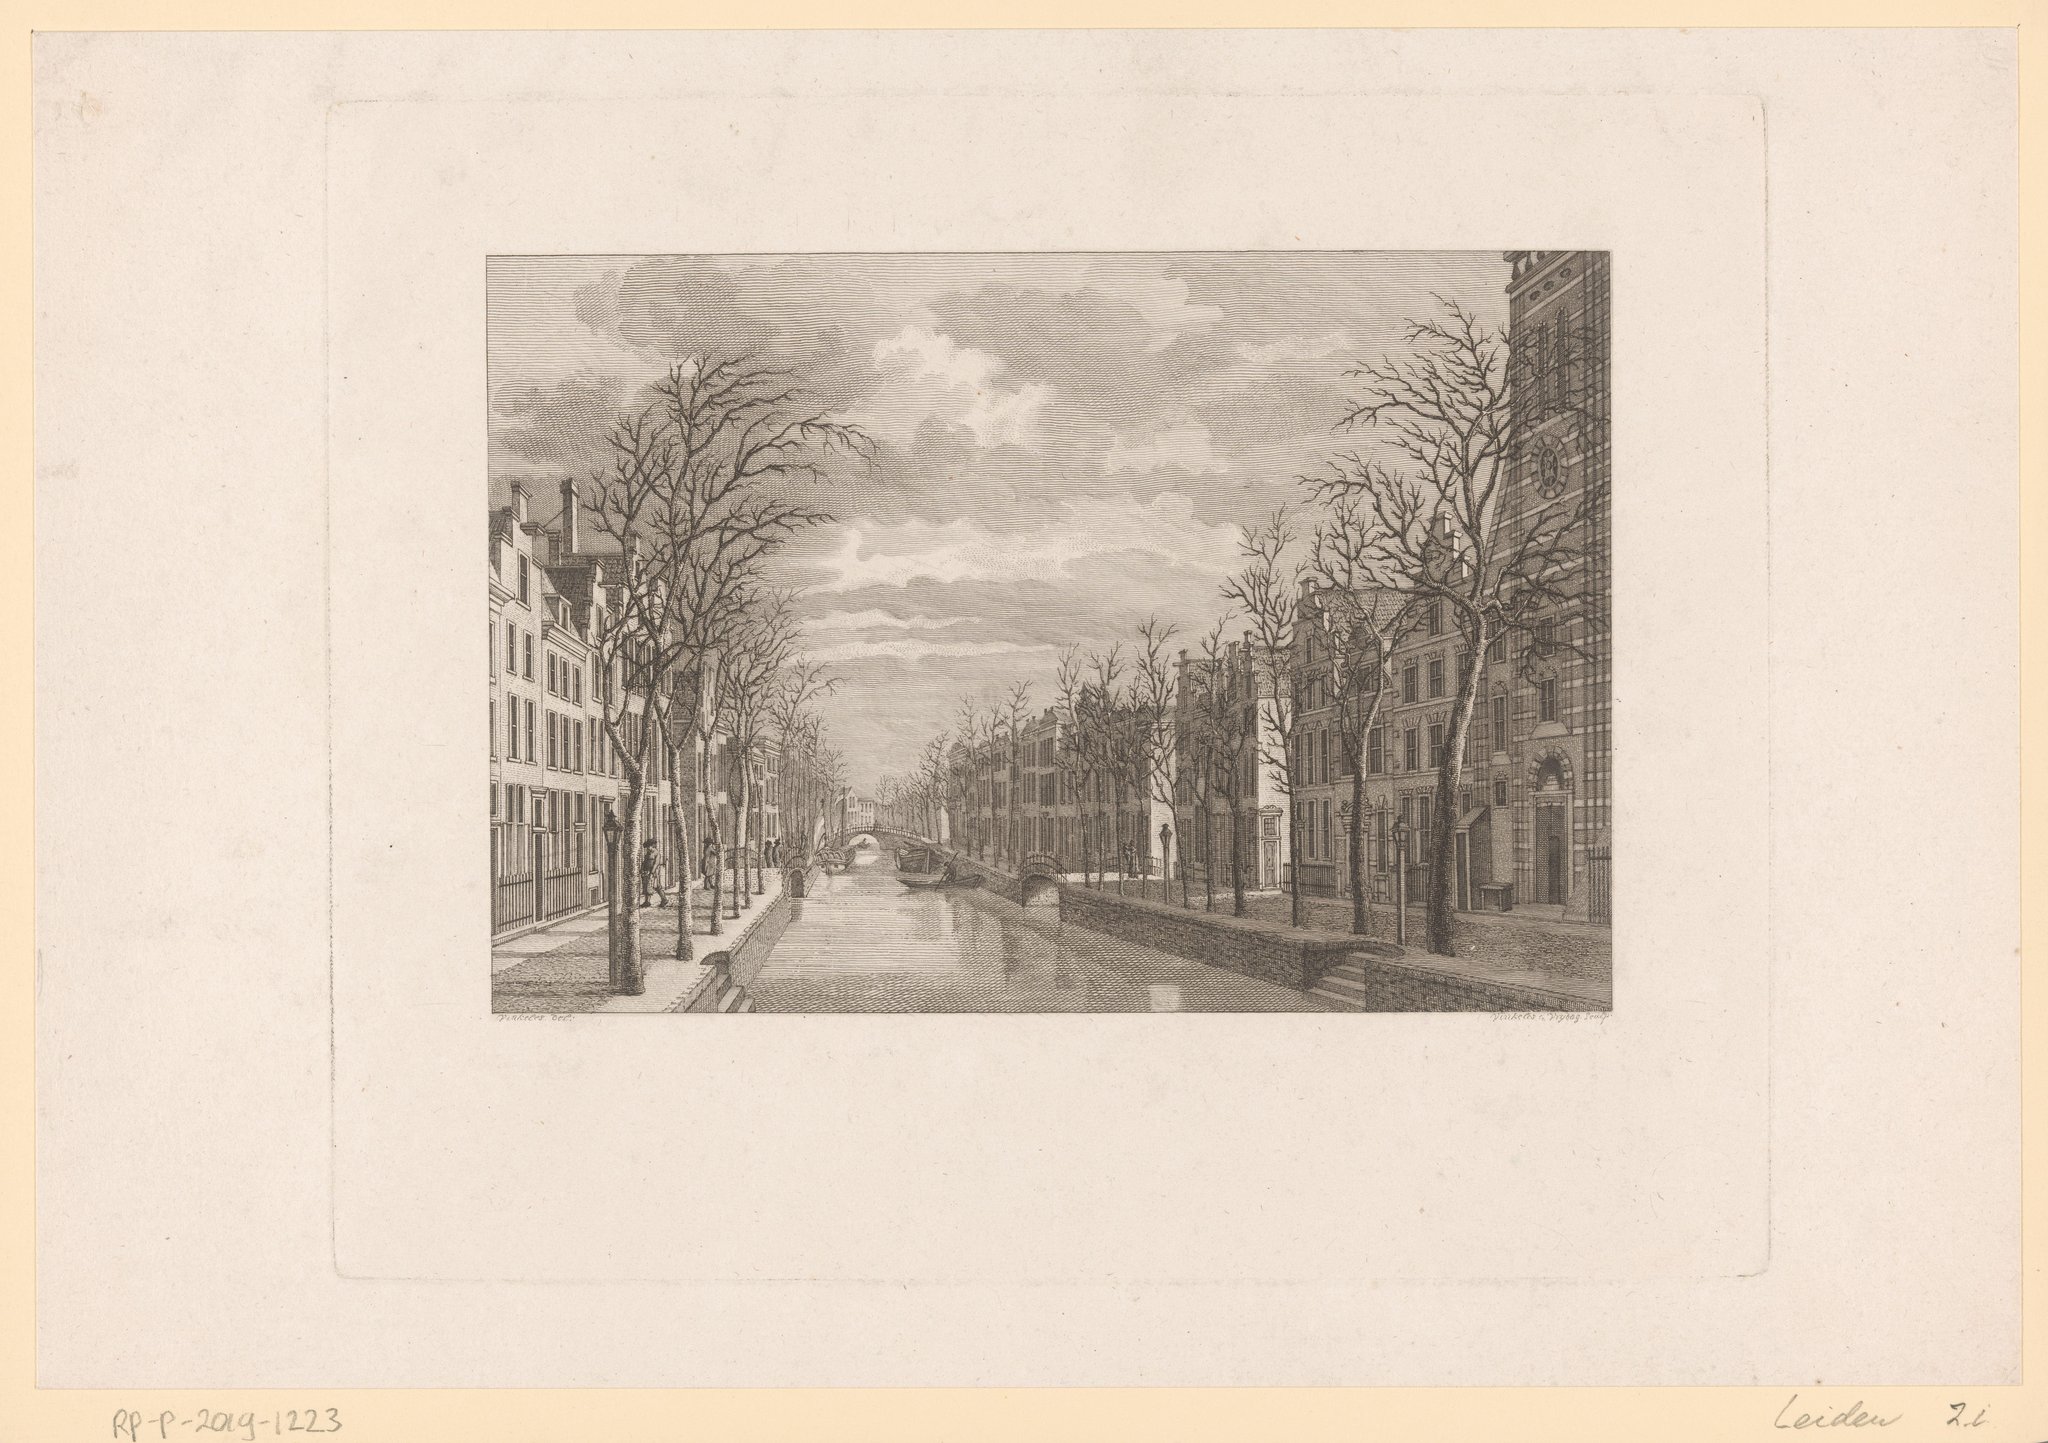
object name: print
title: Rapenburg te Leiden voor de buskruitramp, 12 januari 1807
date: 1808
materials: paper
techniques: engraving, etching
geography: amsterdam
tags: canals, waters (in city)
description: Prent verscheen in tweede staat in: Bilderdijk, Willem, en Matthijs Siegenbeek. Leydens ramp. Amsterdam: Johannes Allart en Jacques Ruis, 1808, tussen p. 8 en 9.